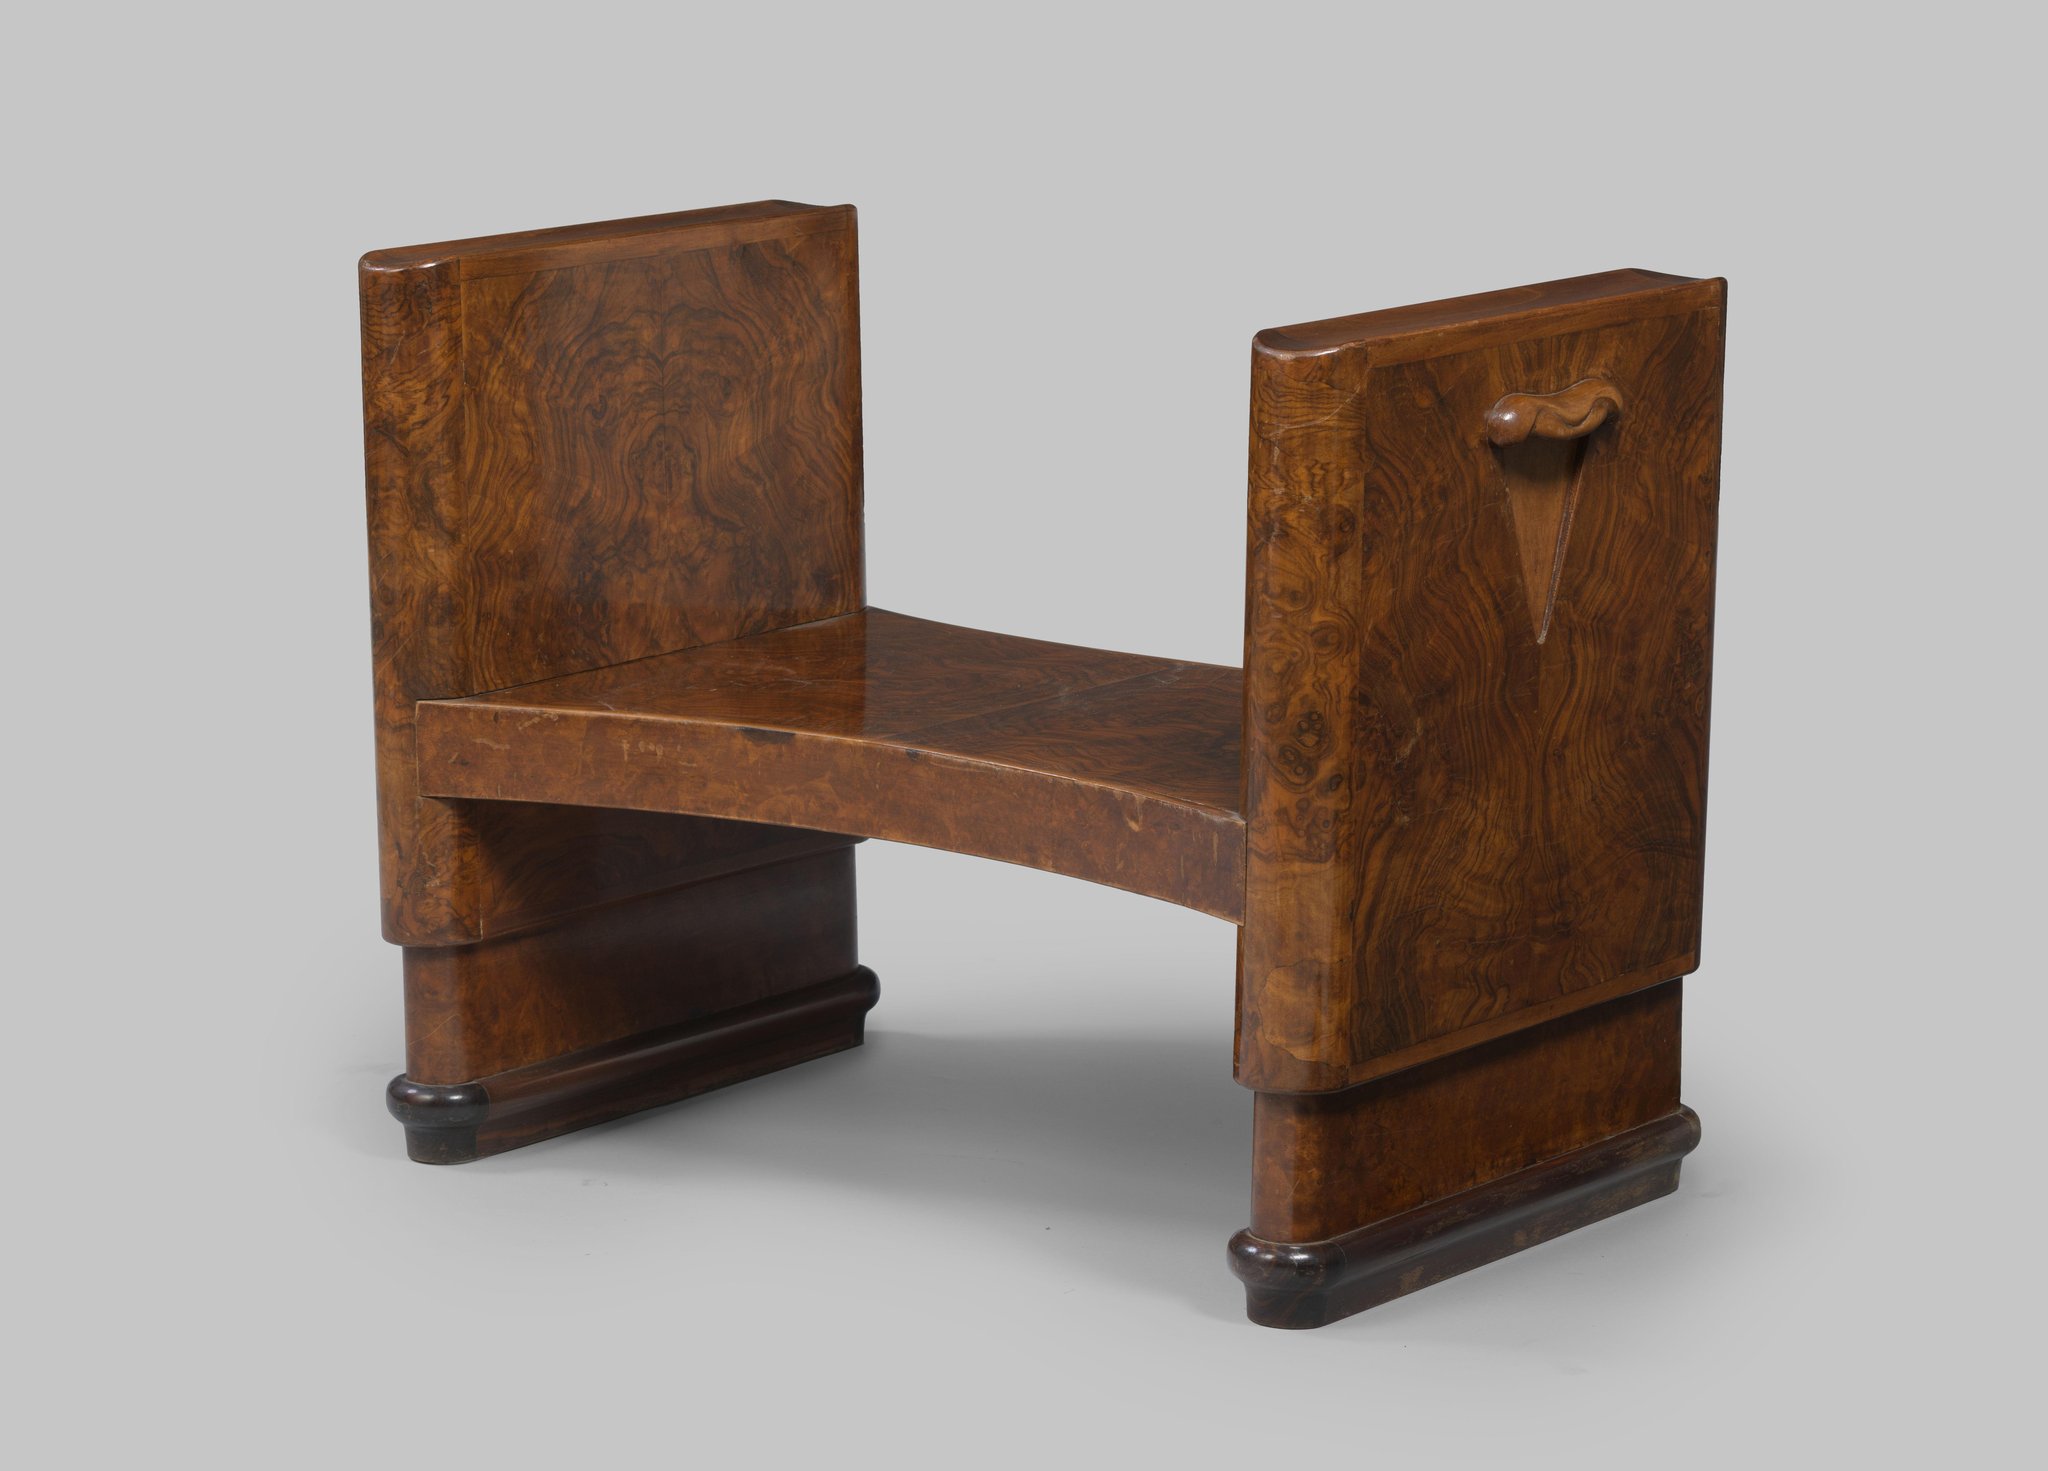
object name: sofa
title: Bank met twee gesloten wangen, aan de bovenkant uitgehold en met golvend handvat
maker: jan de meijer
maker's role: designer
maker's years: 1878-1950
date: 1930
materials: wood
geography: northern netherlands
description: Bank van beuken en iepen, belijmd met wortelnoten-, noten- en palissanderhout. Het meubel heeft twee gesloten wangen die op een iets terugwijkende plint met een coromandelhouten, halfrond geprofileerde voet staan. De wangen die aan de bovenzijde zijn uitgehold, hebben aan de buitenkant een golvend handvat met hieronder een driehoekige uitsparing. De voor- en achterregels van de zitting zijn concaaf. Het fineer op de grotere vlakken bestaat uit twee gespiegelde delen. De bank is onderdeel van een ameublement.